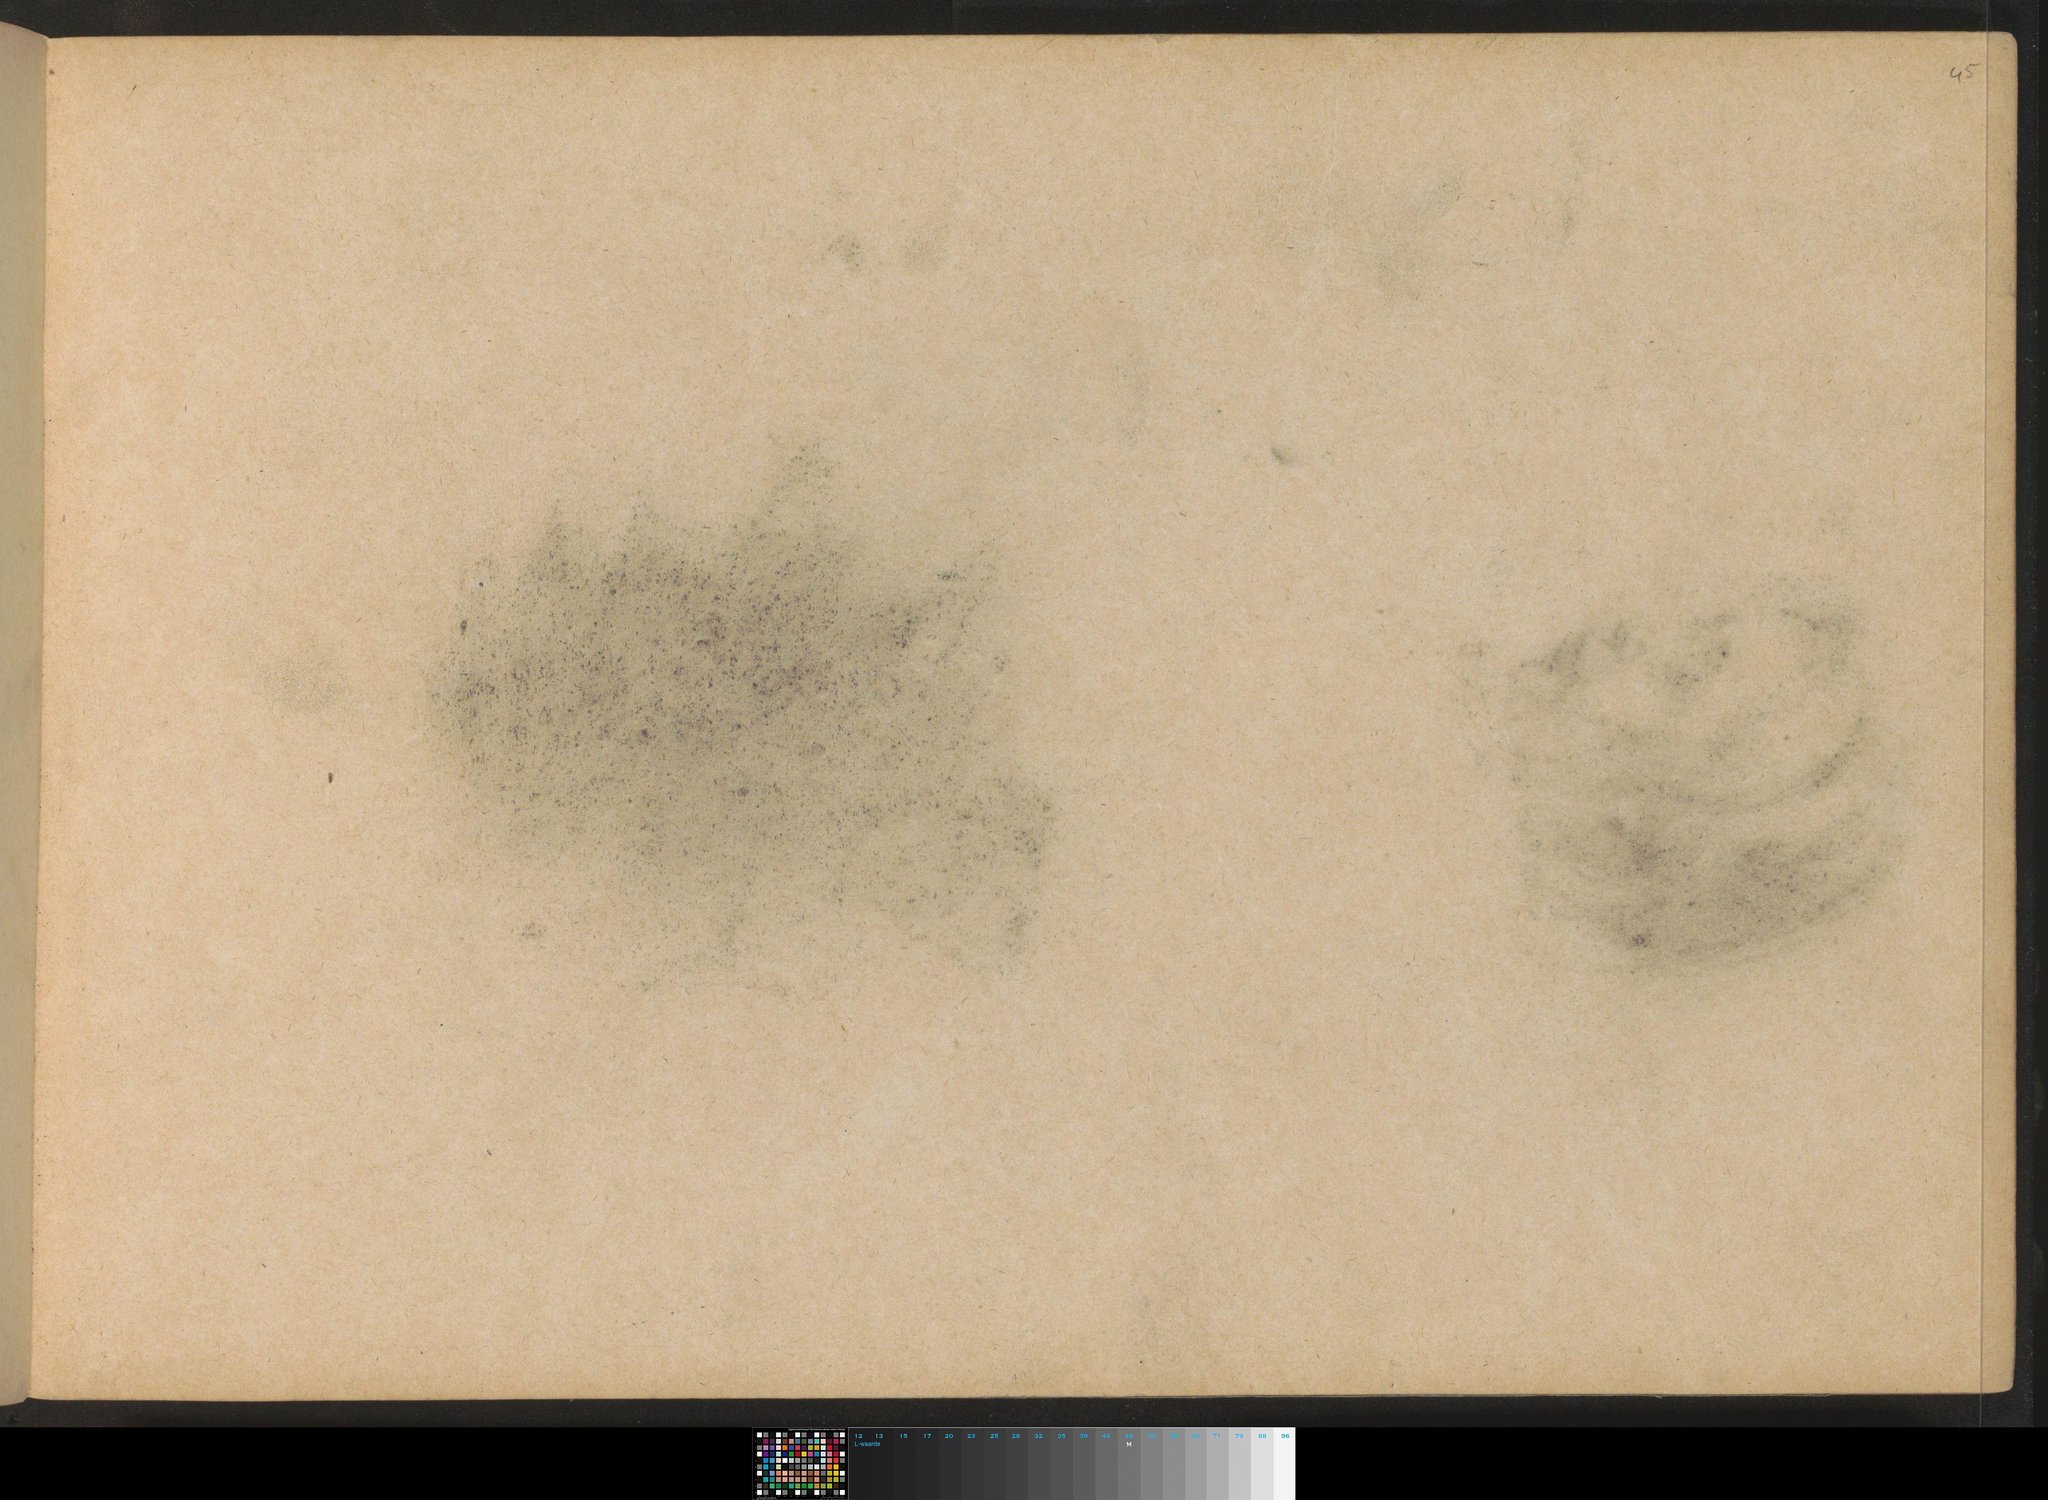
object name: sketchbook leaf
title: Abklatsch van de krijttekening op pagina 44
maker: willem witsen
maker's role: draughtsman, painter, print maker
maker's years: 1860-1923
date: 1884-1887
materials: paper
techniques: printmaking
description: Pagina 45 uit een schetsboek met 29 bladen.